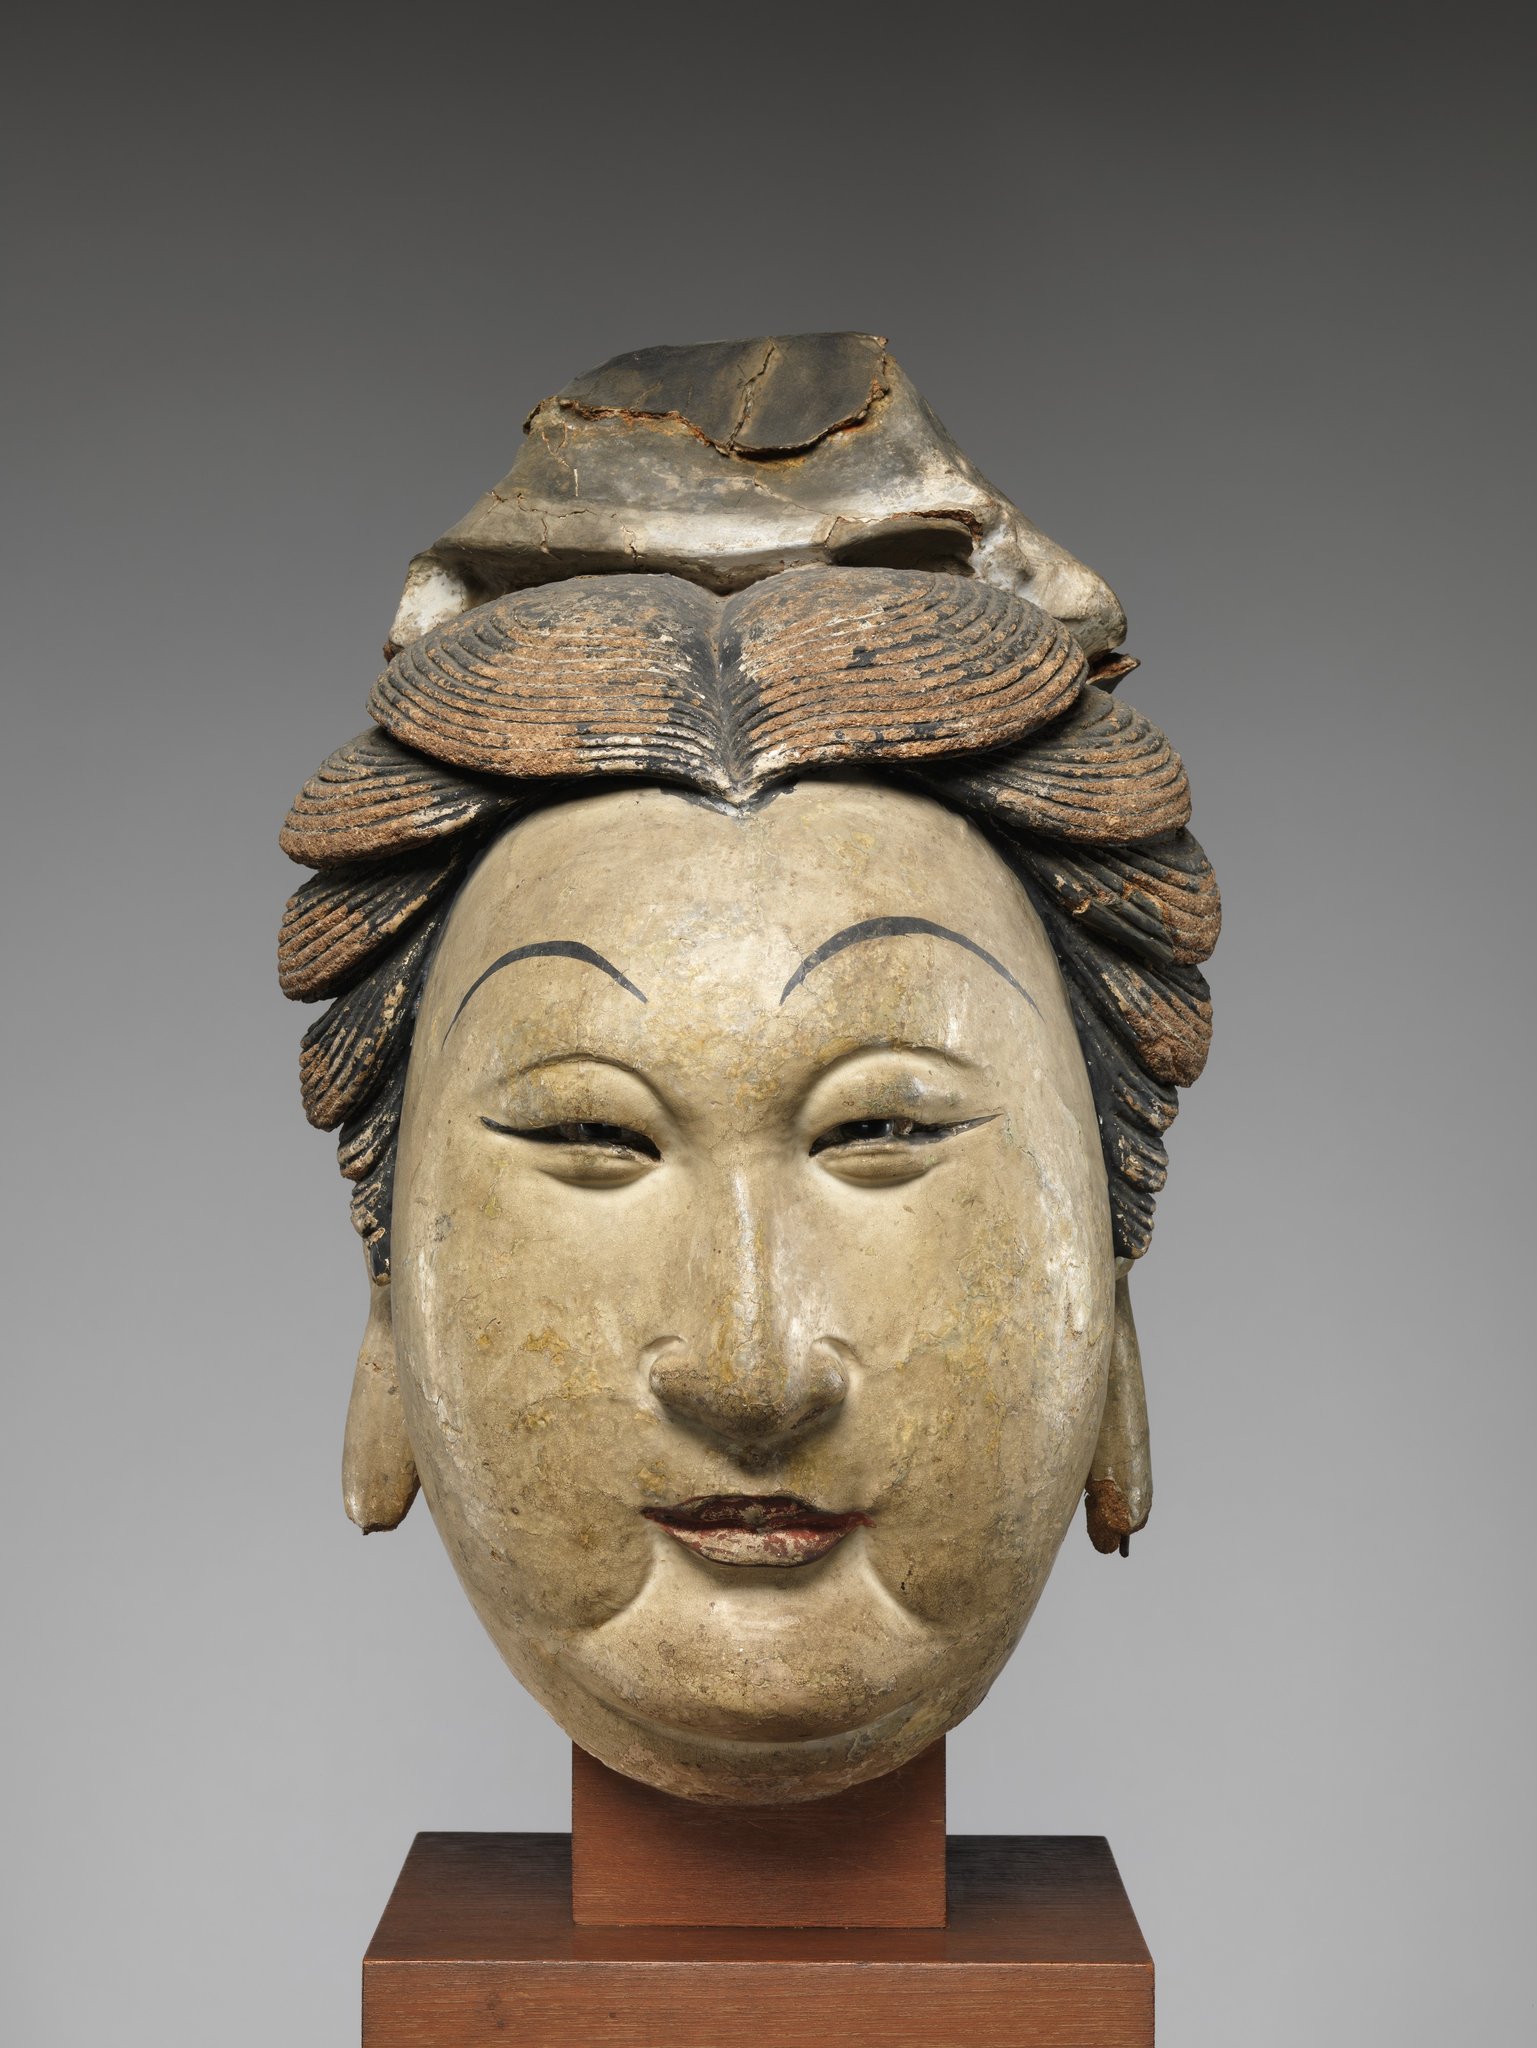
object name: head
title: Head of Attendant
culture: chinese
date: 1001-1200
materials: clay, pigment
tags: human figures,heads